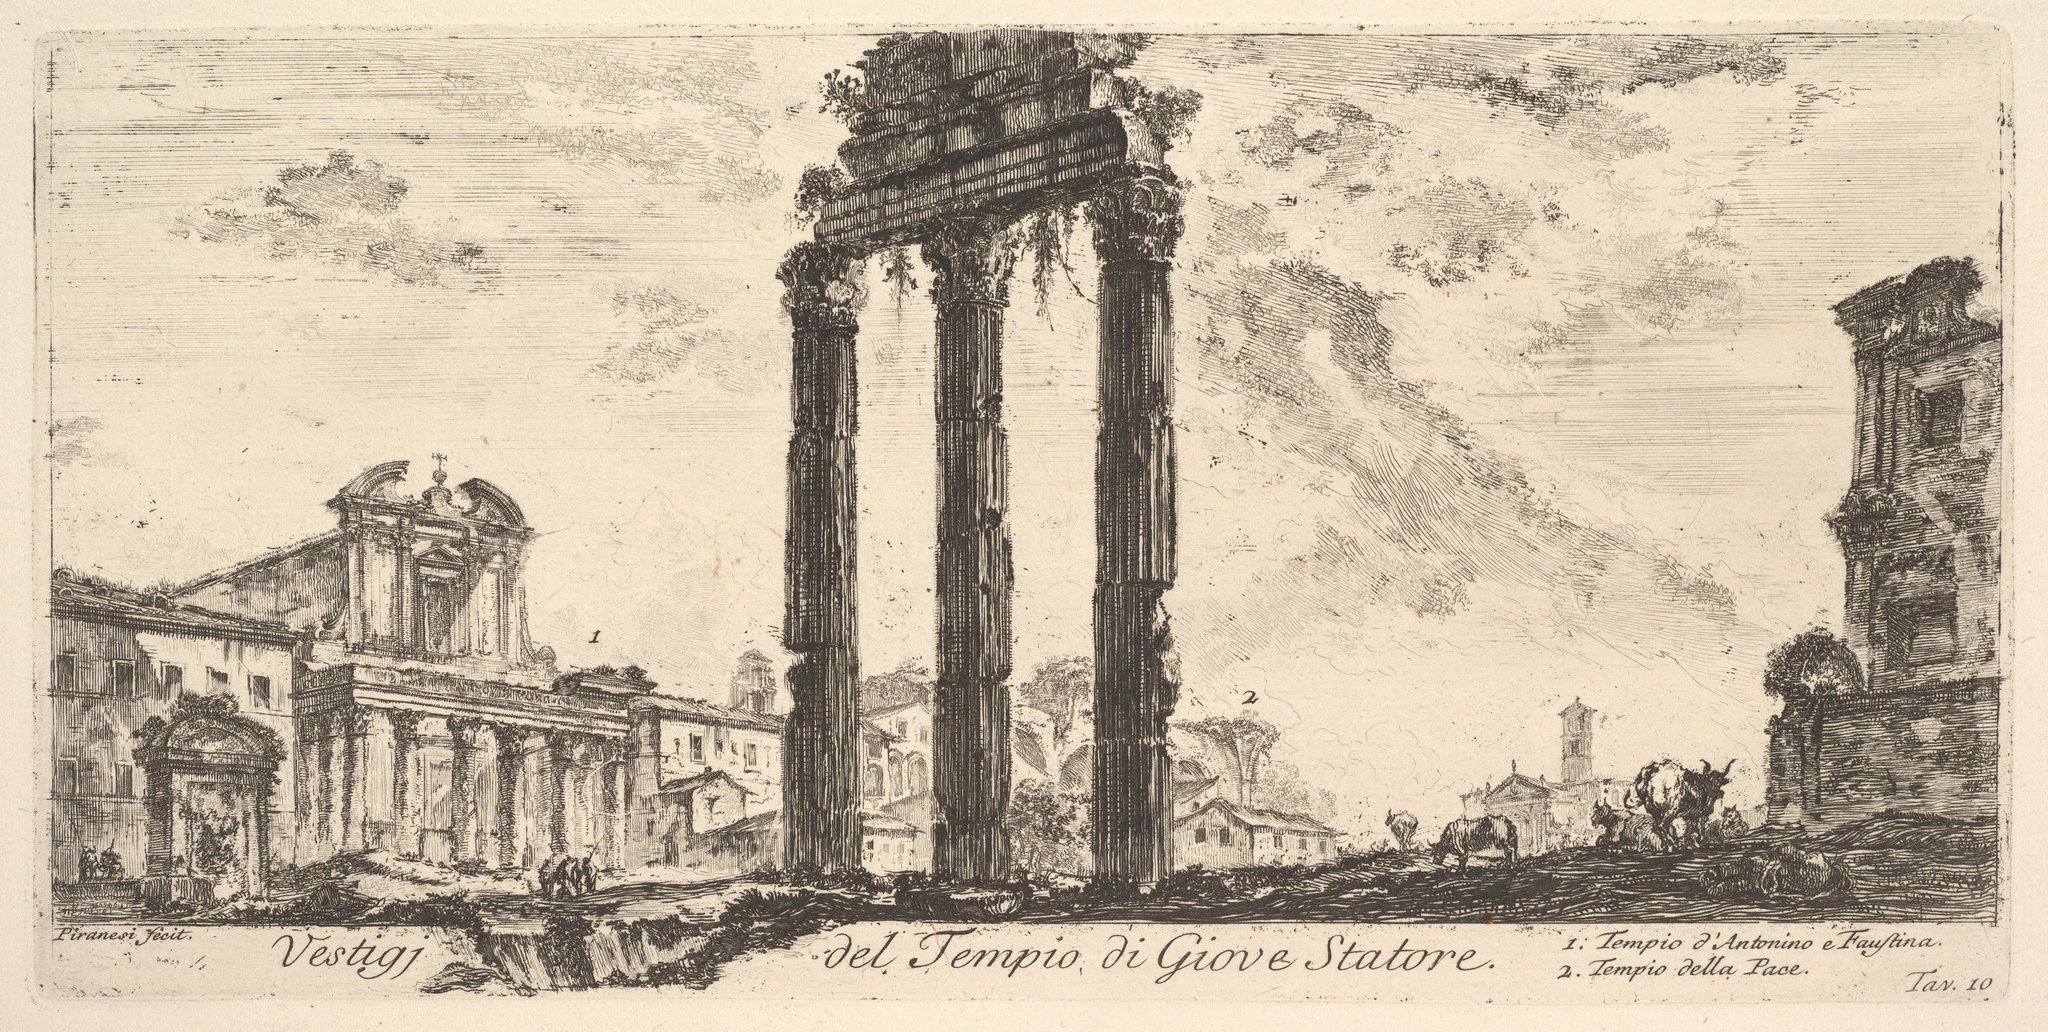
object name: print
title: Plate 10: Ruins of the Temple of Jupiter Stator (Jupiter the Supporter). 1. Temple of Antoninus and Faustina. 2. Temple of Peace. (Vestigi del Tempio di Giove Statore. 1. Tempio d'Antonino e Faustina. 2. Tempio della Pace.), from "Antichità Romane de' Tempi della Repubblica, e de' primi Imperatori"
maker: giovanni battista piranesi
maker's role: artist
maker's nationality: italian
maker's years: 1720-1778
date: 1748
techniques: etching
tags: columns,temples,ruins